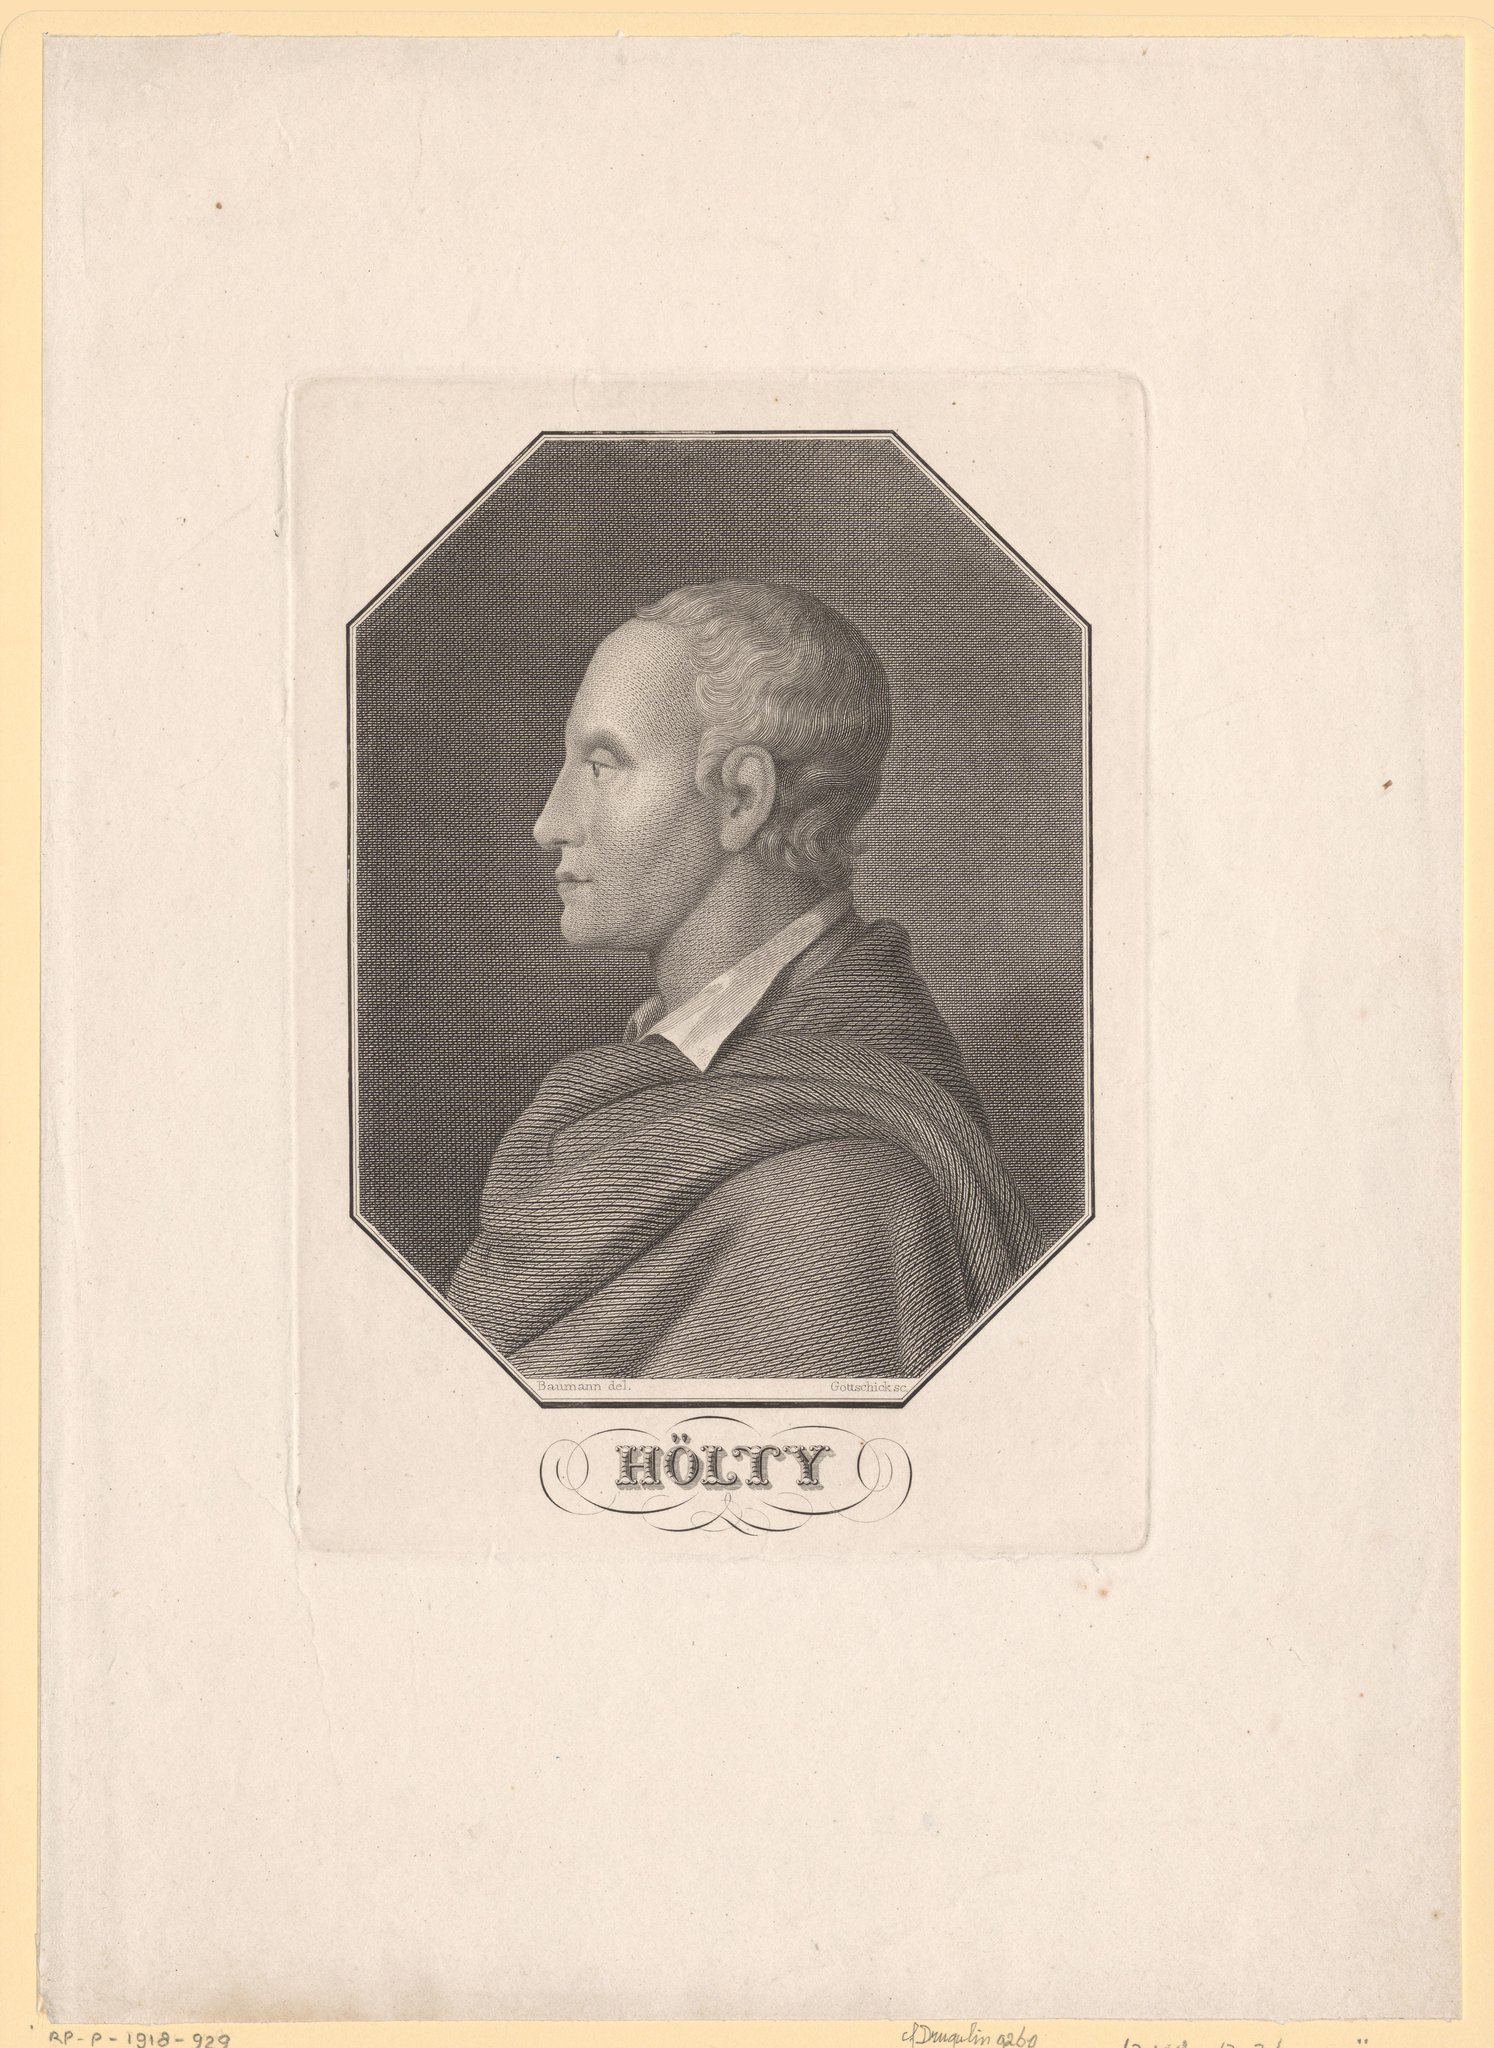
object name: print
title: Portret van Ludwig Hölty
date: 1786-1844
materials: paper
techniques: engraving, etching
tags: historical persons, writer, poet, author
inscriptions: collector's mark: Lugt 2233